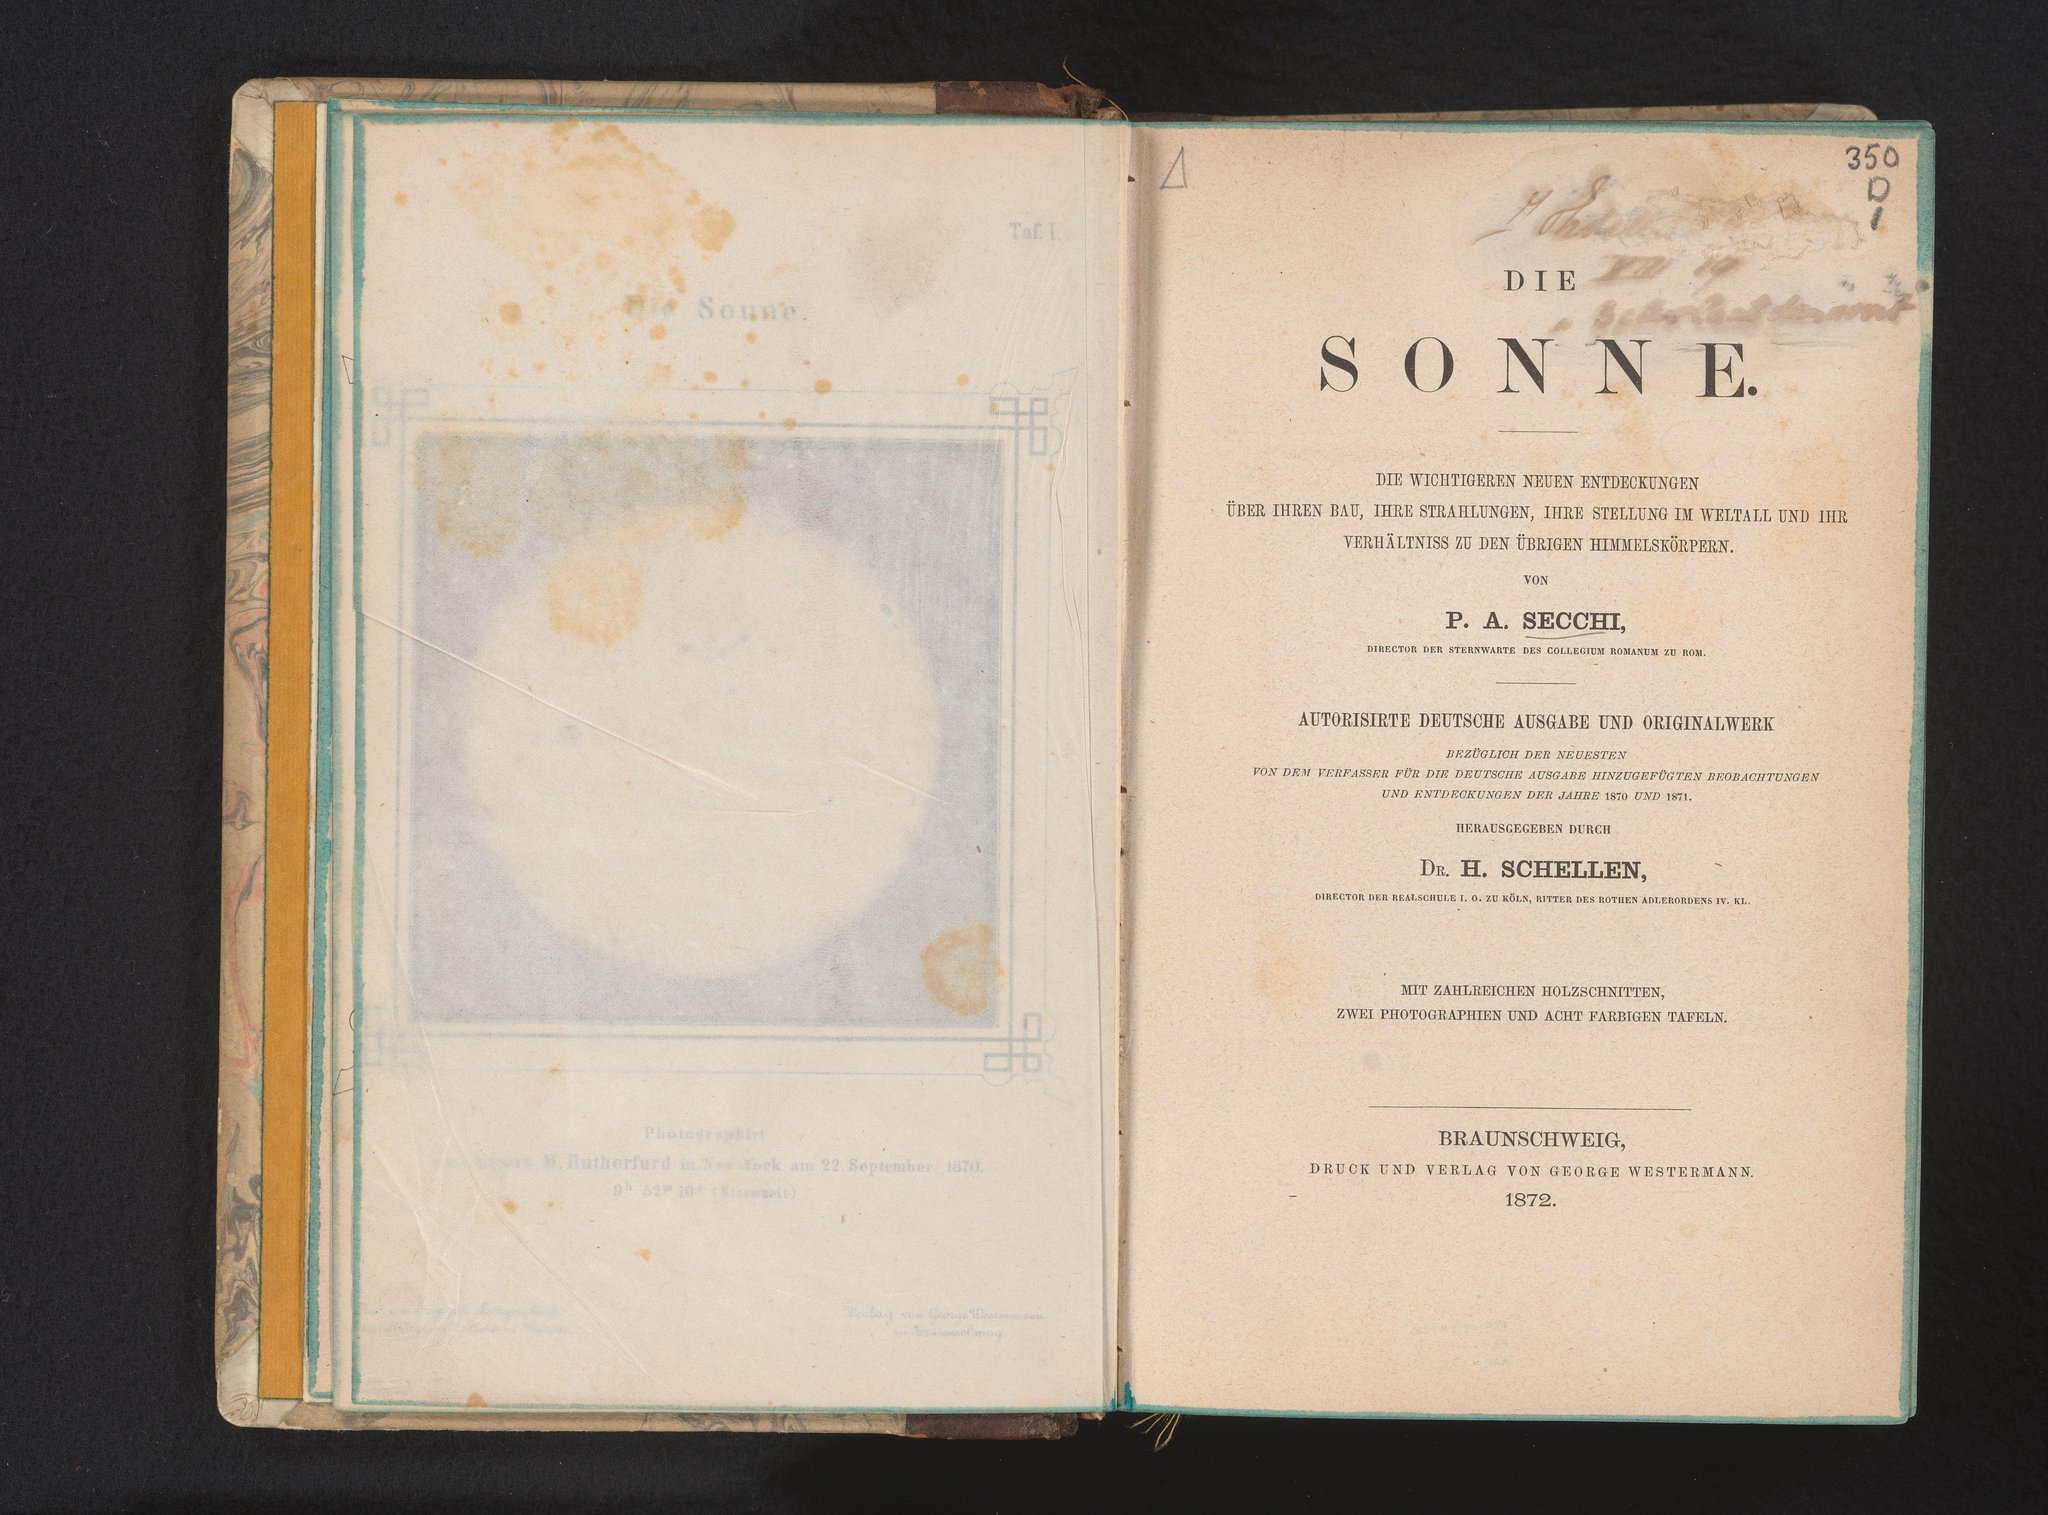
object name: book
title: Die Sonne : die wichtigeren neuen Entdeckungen über ihren Bau, ihre Strahlungen, ihre Stellung im Weltall und ihr Verhältniss zu den übrigen Himmelskörpern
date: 1872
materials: cardboard, paper, leather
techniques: albumen print, letterpress printing, lithograph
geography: berlin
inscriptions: inscription: ‘1e/ 2 photogr’, inscription: ‘Kb/ 75=’